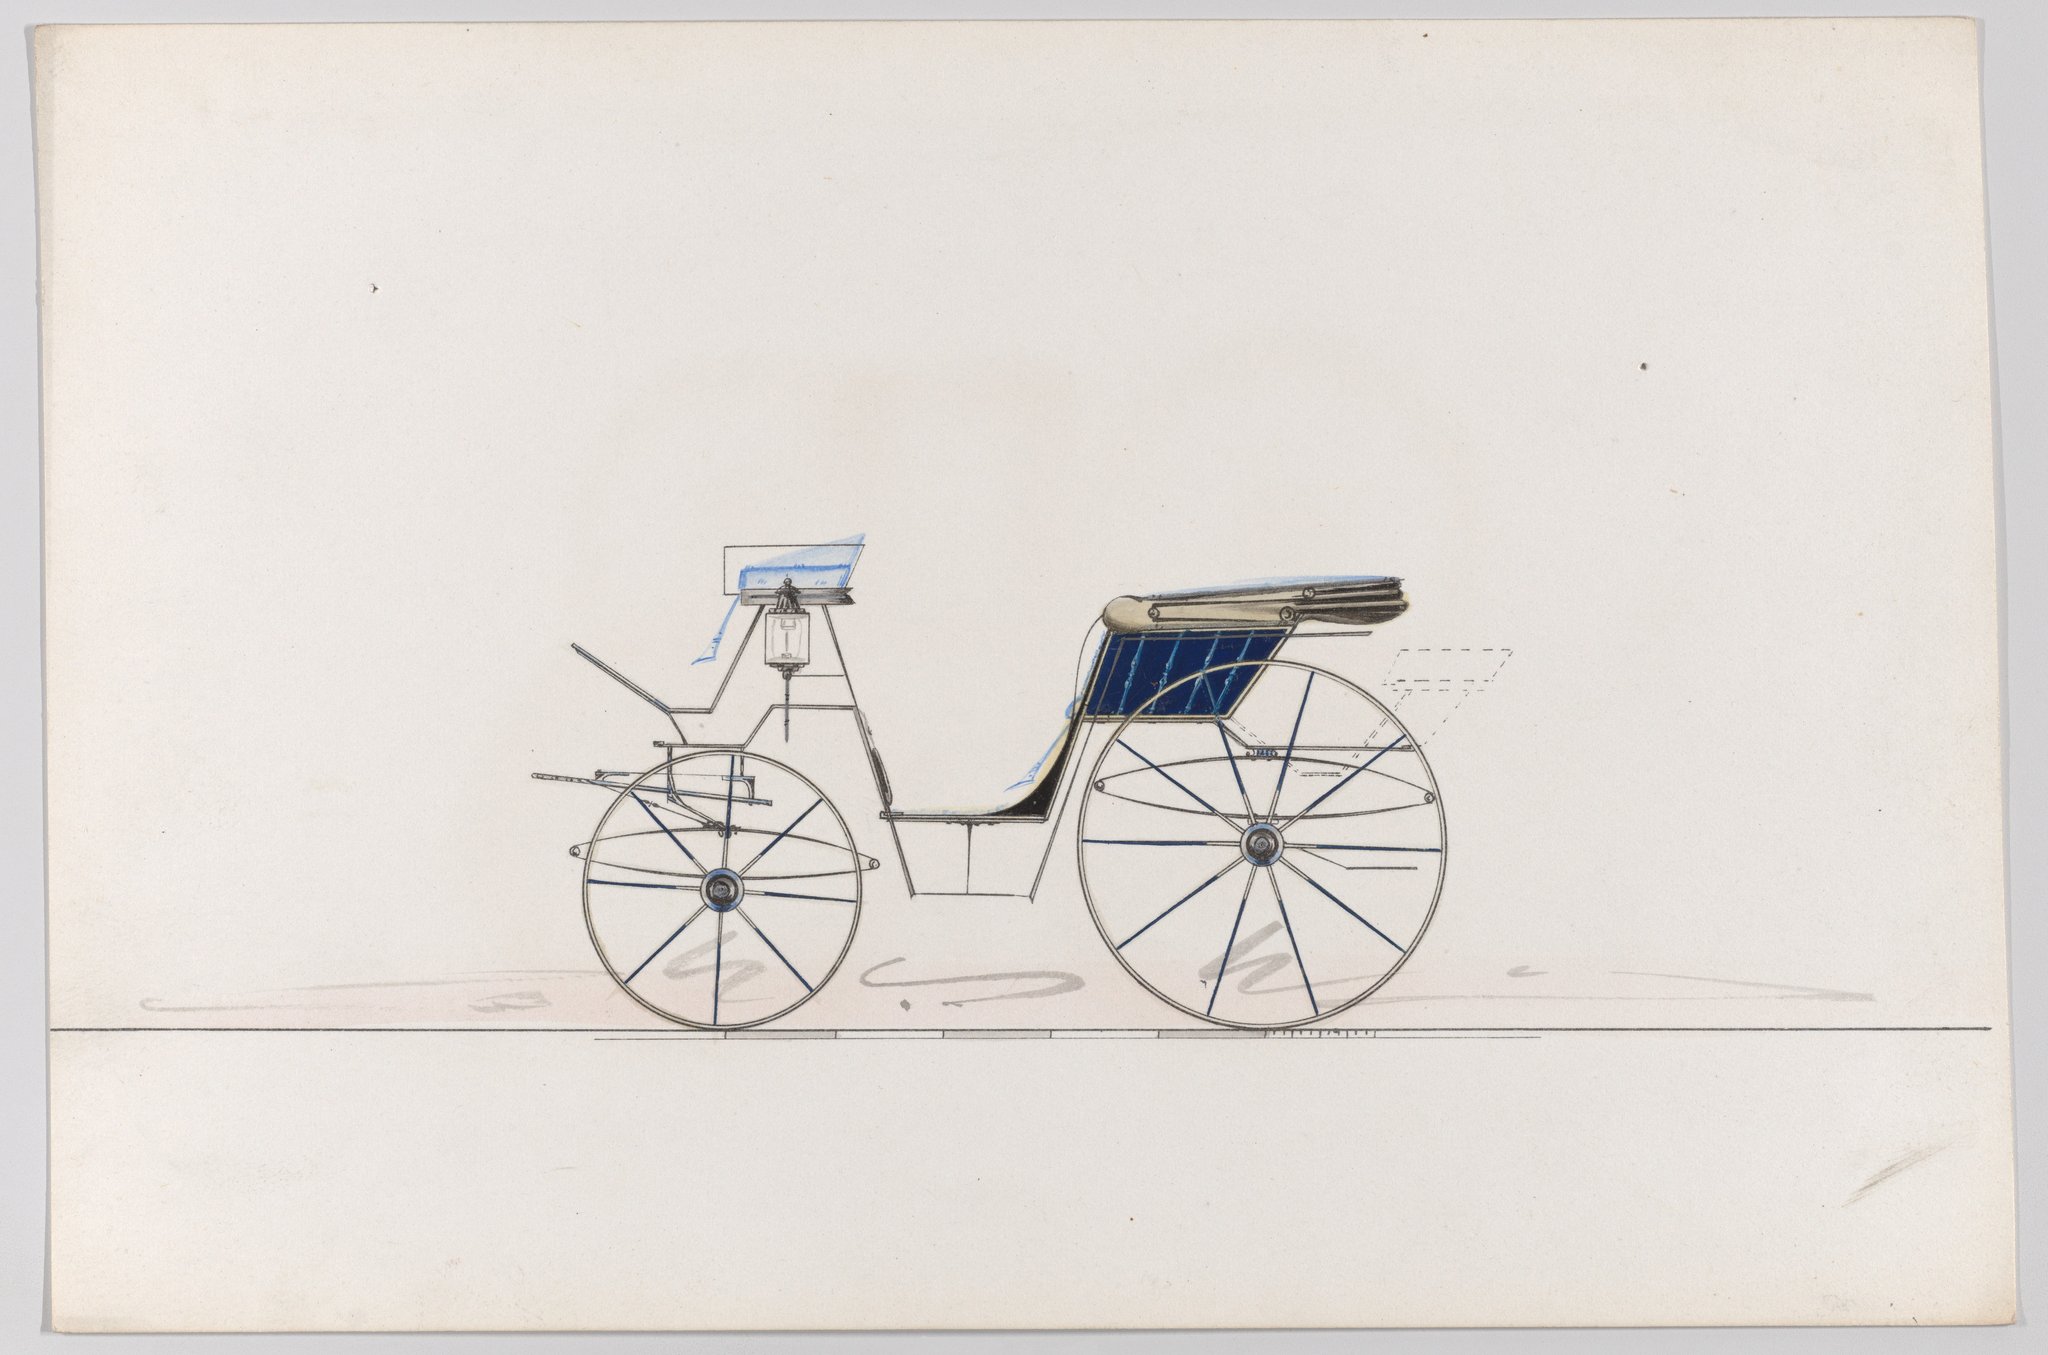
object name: drawing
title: Design for Cabriolet Phaeton(unnumbered)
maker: brewster & co.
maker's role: manufacturer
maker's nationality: american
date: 1870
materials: gouache, gum arabic, ink, watercolor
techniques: pen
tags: carriages